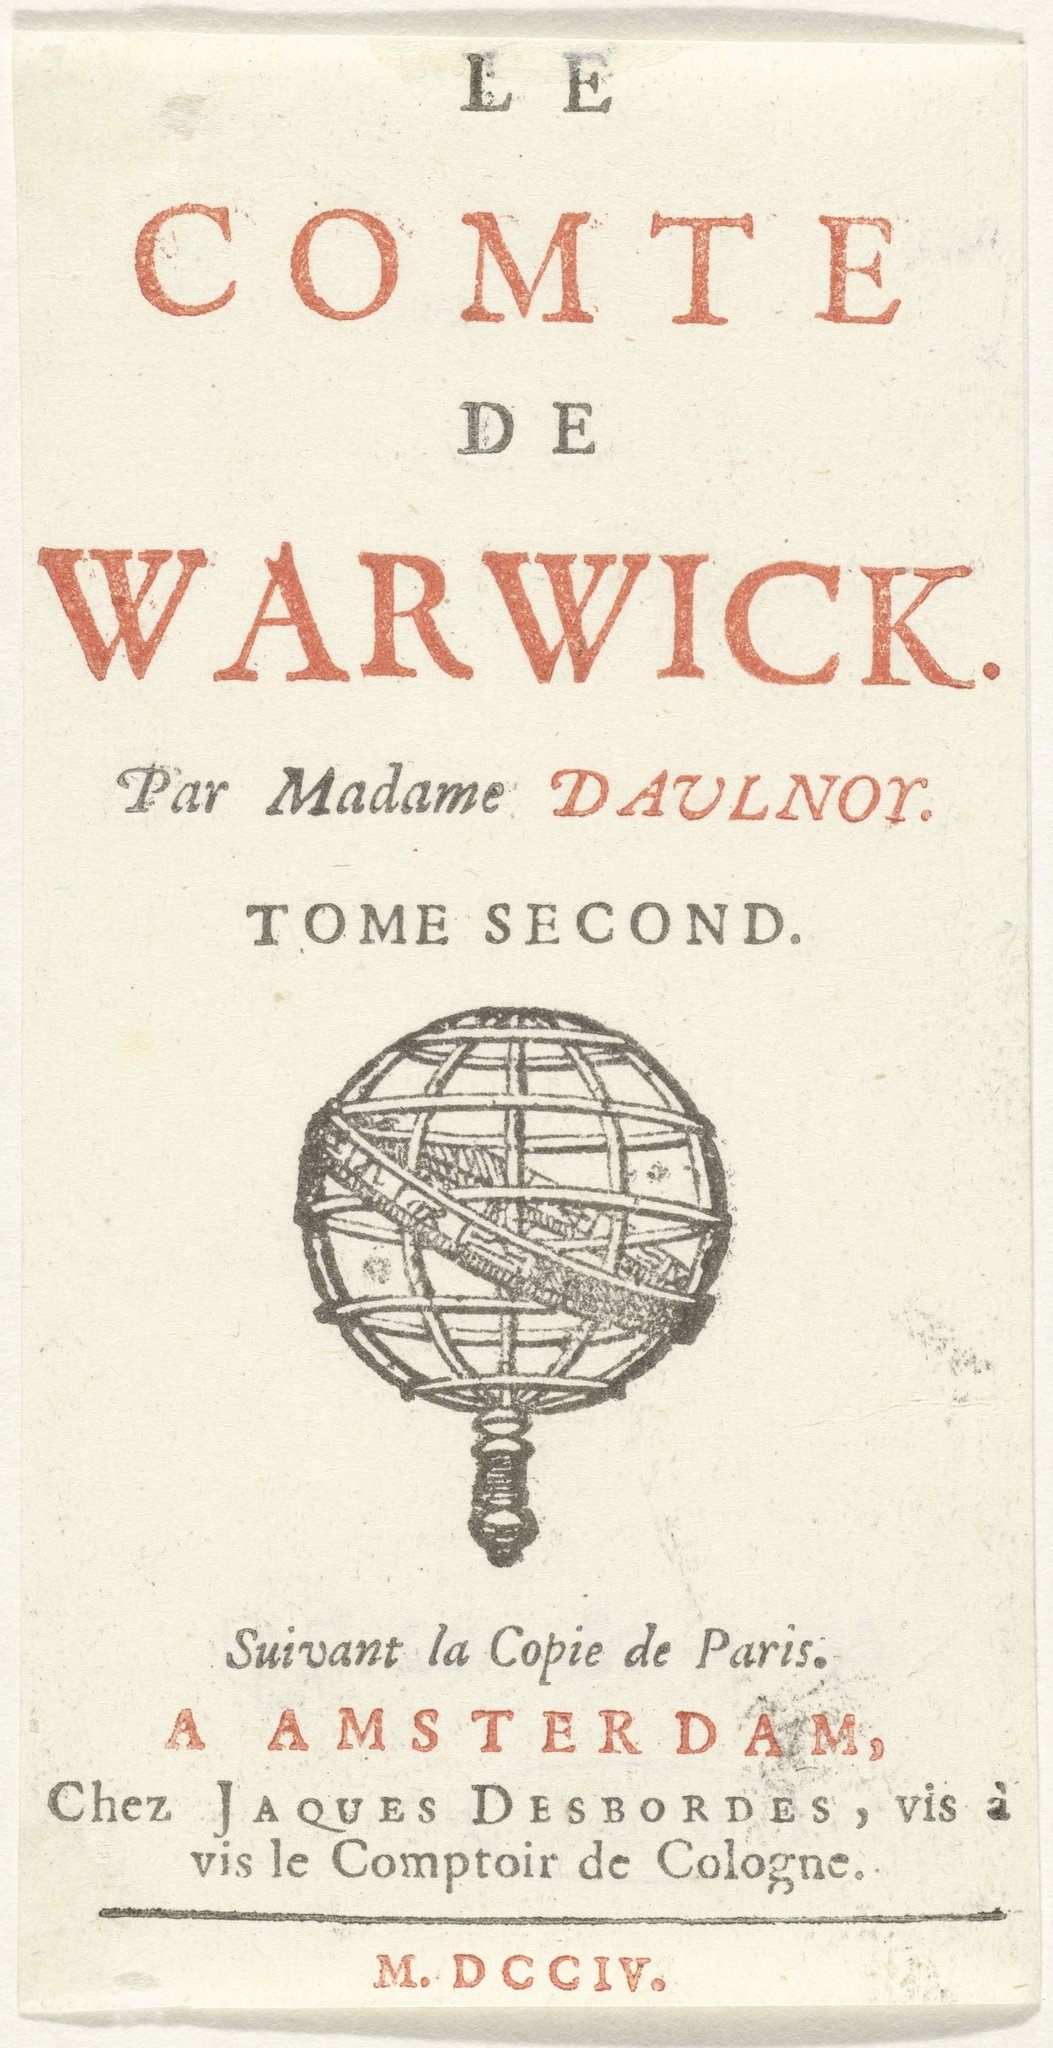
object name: titelblad, titelpagina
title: Titelpagina voor: M. D'Aulnoy, Le comte de Warwick, 1704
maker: jacques desbordes (i)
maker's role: publisher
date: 1704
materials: paper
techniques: letterpress printing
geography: amsterdam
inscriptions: collector's mark: Lugt 2228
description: Titelpagina voor het tweede deel van: Aulnoy, Marie Cathérine Le Jumel de Barneville d' (comtesse). Le comte de Warwick. Amsterdam: Jacques Desbordes (I), 1704.